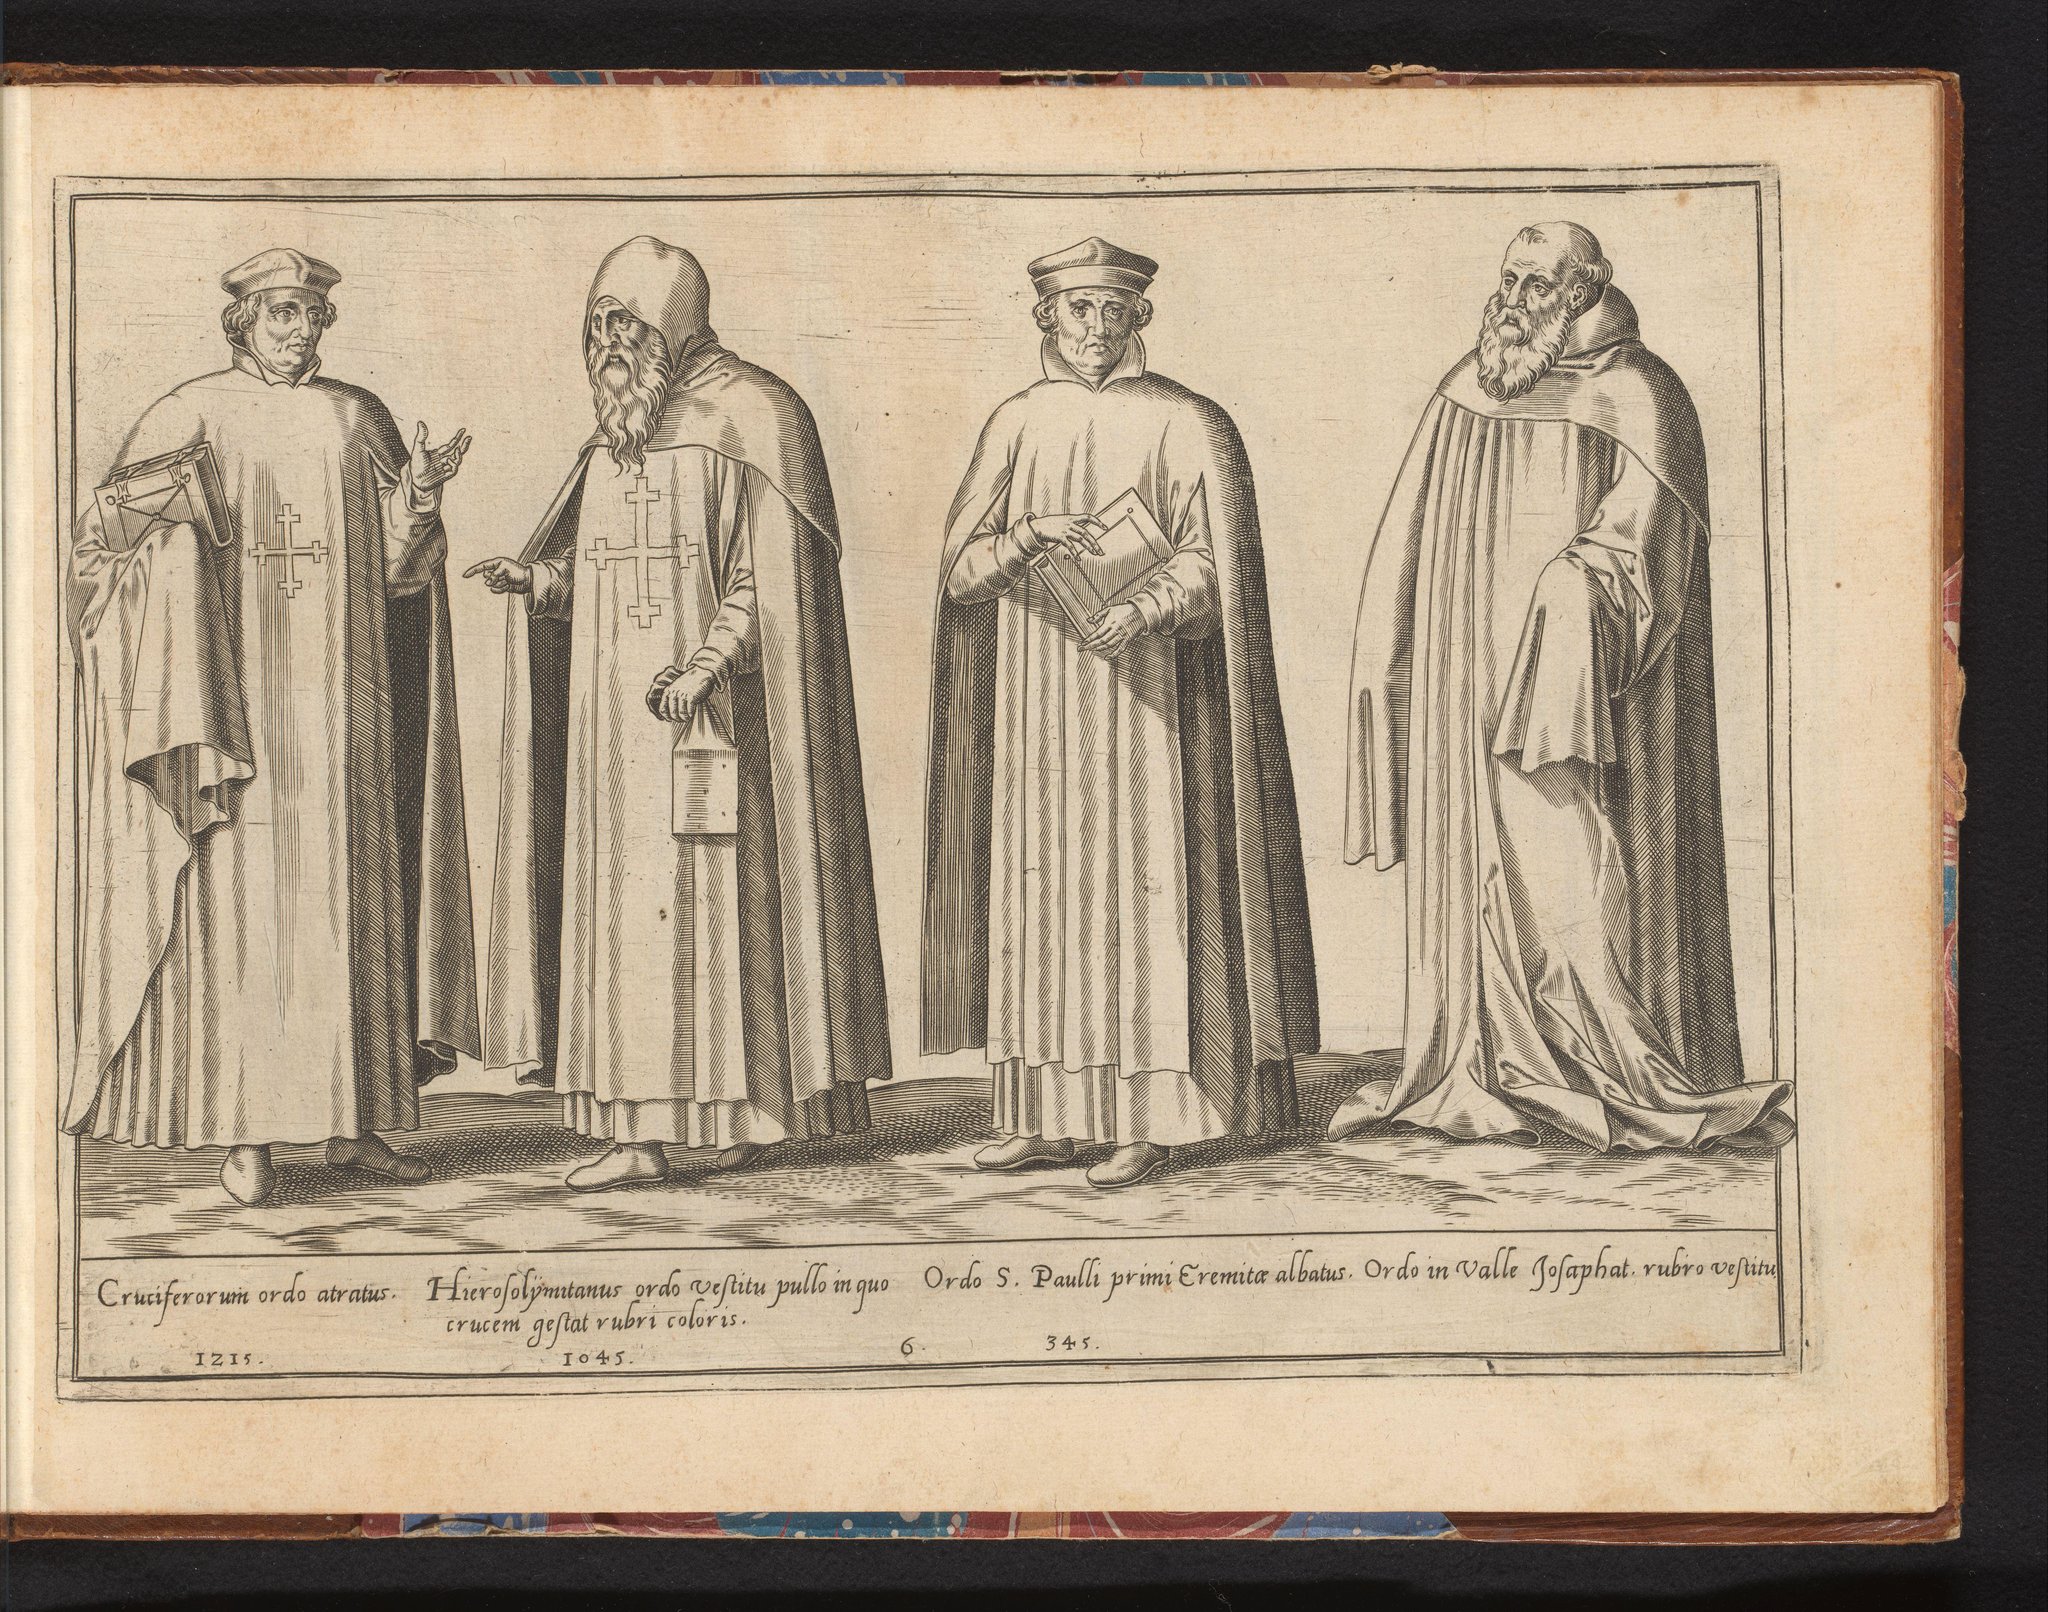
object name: costume print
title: Vier monniken uit verschillende orden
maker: abraham de bruyn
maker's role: print maker, publisher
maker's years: 1540-1587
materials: paper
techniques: engraving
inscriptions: number: ‘6’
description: Prent uit het boek 'Omnium pene Europae, Asiae, Aphricae atque Americae gentium habitus...', 1581. De prent maakt deel uit van een album.